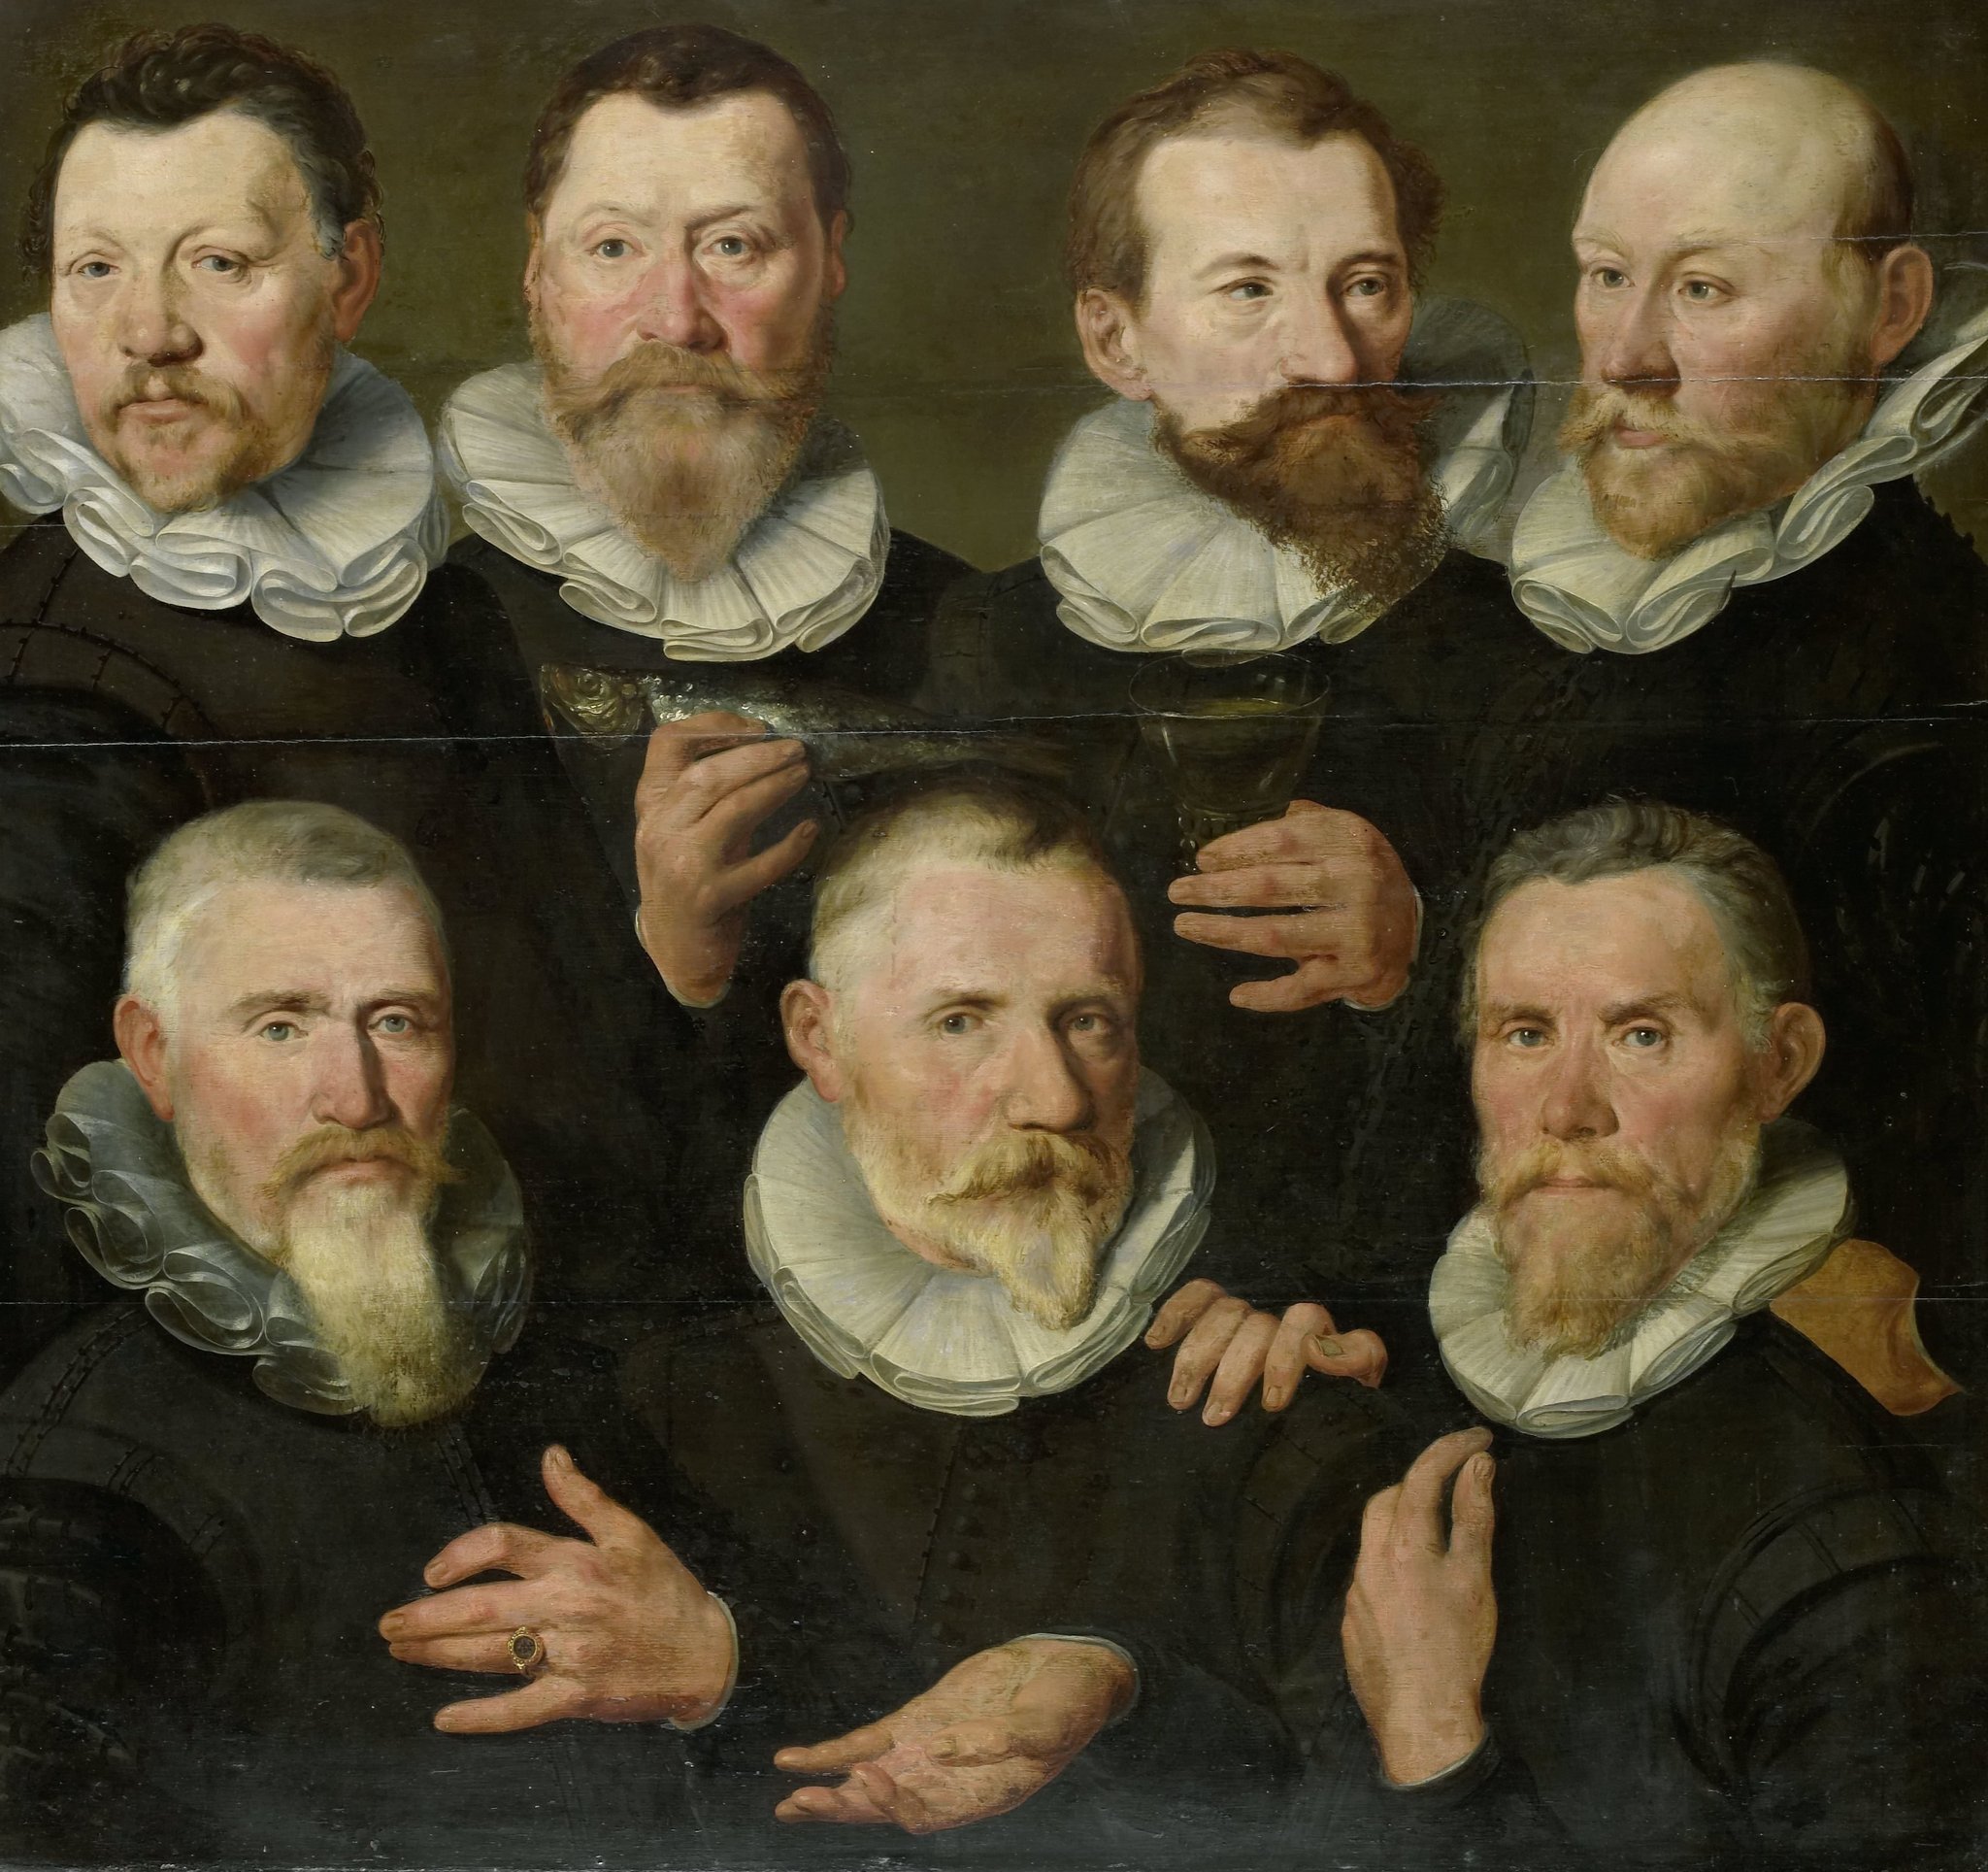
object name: fragment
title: The Company of Captain Pieter Dircksz Hasselaer and Lieutenant Jan Gerritsz Hooft, Amsterdam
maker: pieter pietersz. (i)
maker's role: painter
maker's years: 1540-1603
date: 1595-1605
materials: oil, panel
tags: haarlem, amsterdam, warfare; military affairs (+ citizen soldiery, civil guard, citizen militia)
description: Het korporaalschap van kapitein Pieter Dircksz Hasselaer en luitenant Jan Gerritsz Hooft, van de Kloveniersdoelen te Amsterdam. Bustes van zeven mannen, één met een glas en één met een vis in de hand.